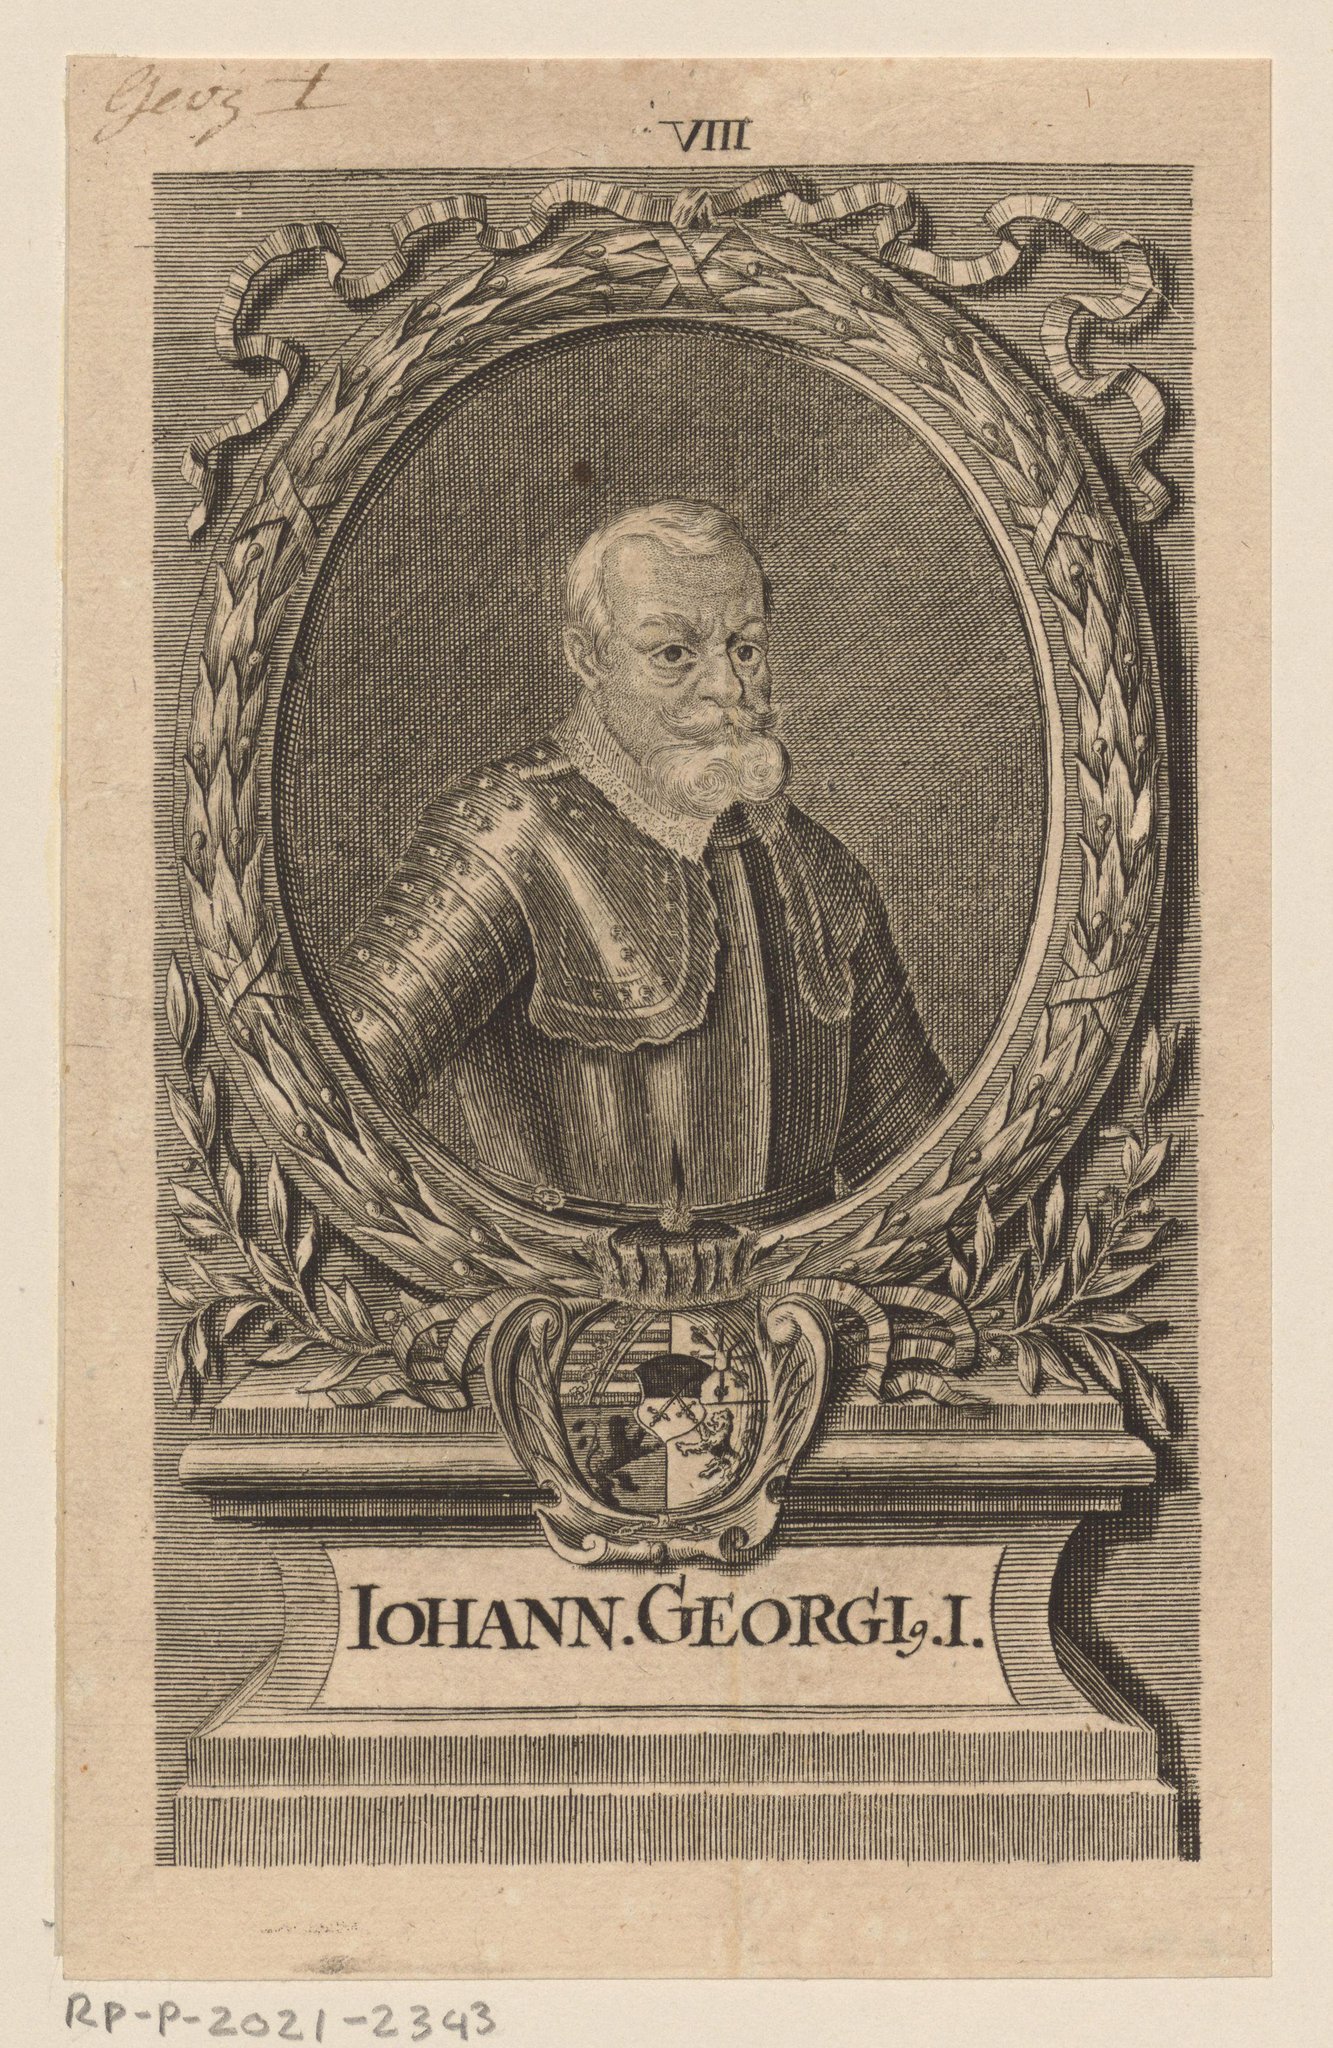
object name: print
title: Portret van Johann George I van Saksen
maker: Anonymous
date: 1650-1749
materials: paper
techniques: engraving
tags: johann george van saksen (i), historical persons, ruler, sovereign, armorial bearing, heraldry